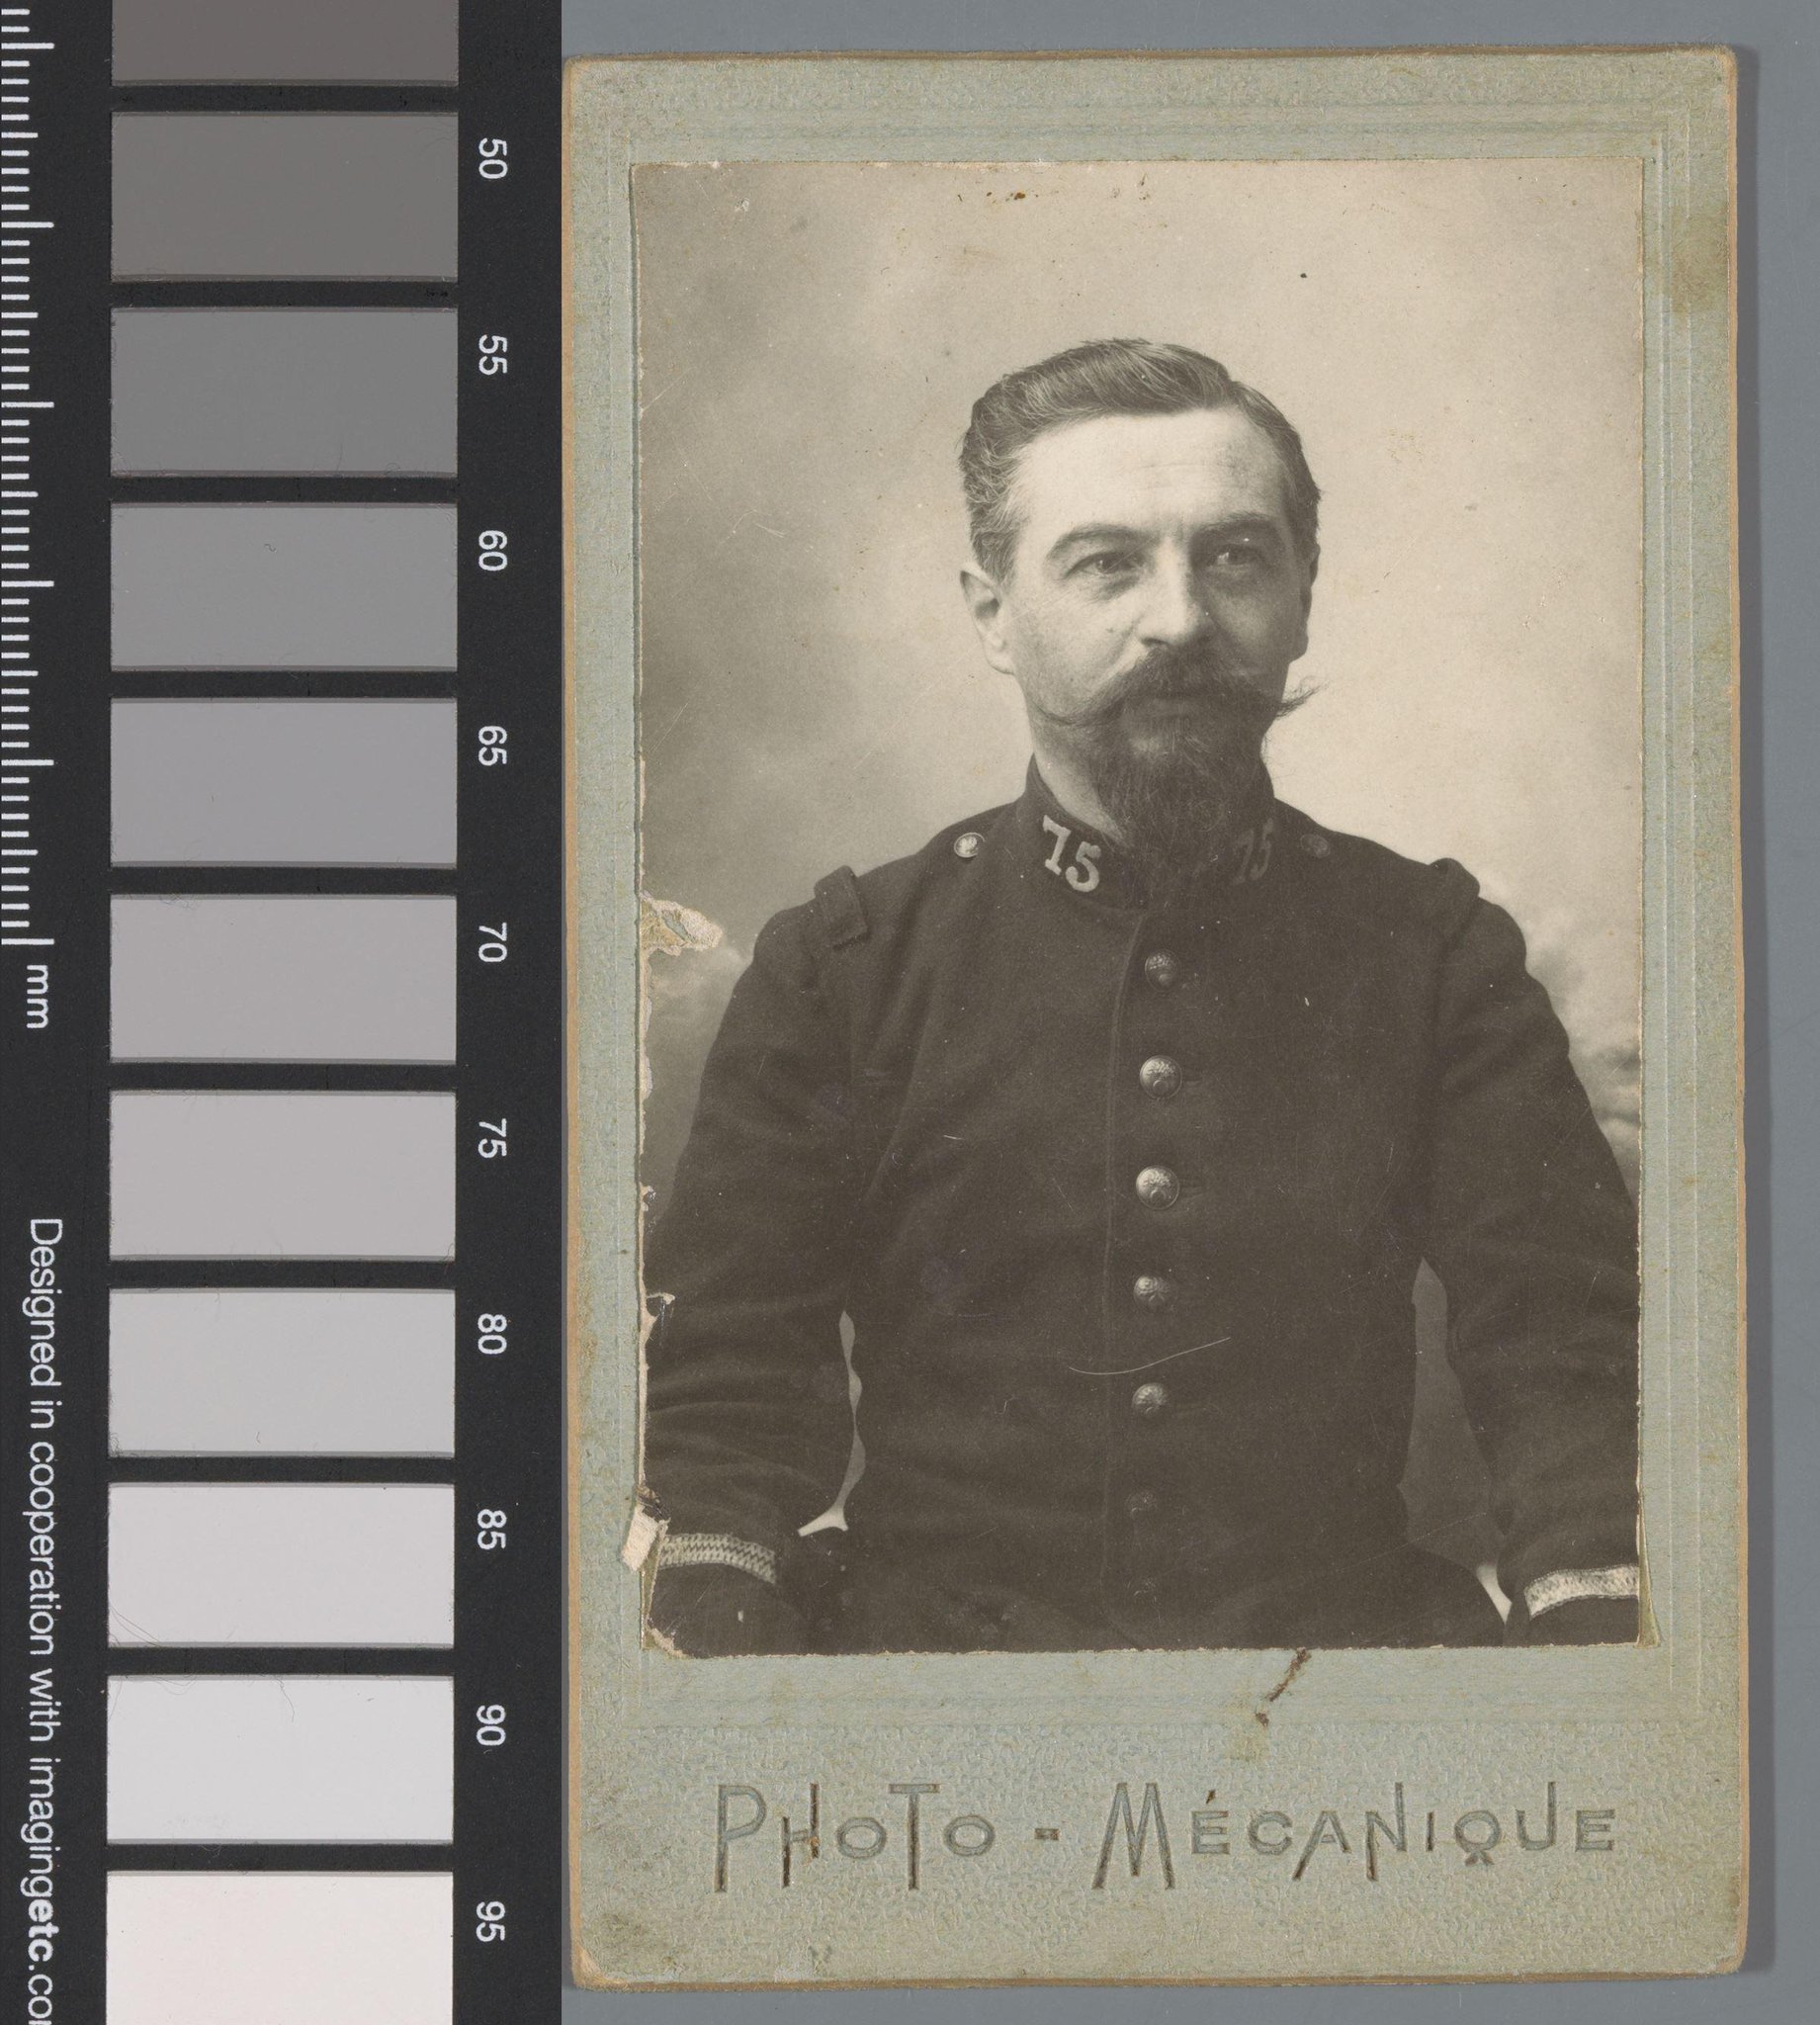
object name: photograph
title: Portret van een onbekende man in uniform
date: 1914-1922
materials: paper, cardboard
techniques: gelatin silver print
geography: paris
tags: adult man, anonymous historical person portrayed, (military) uniforms